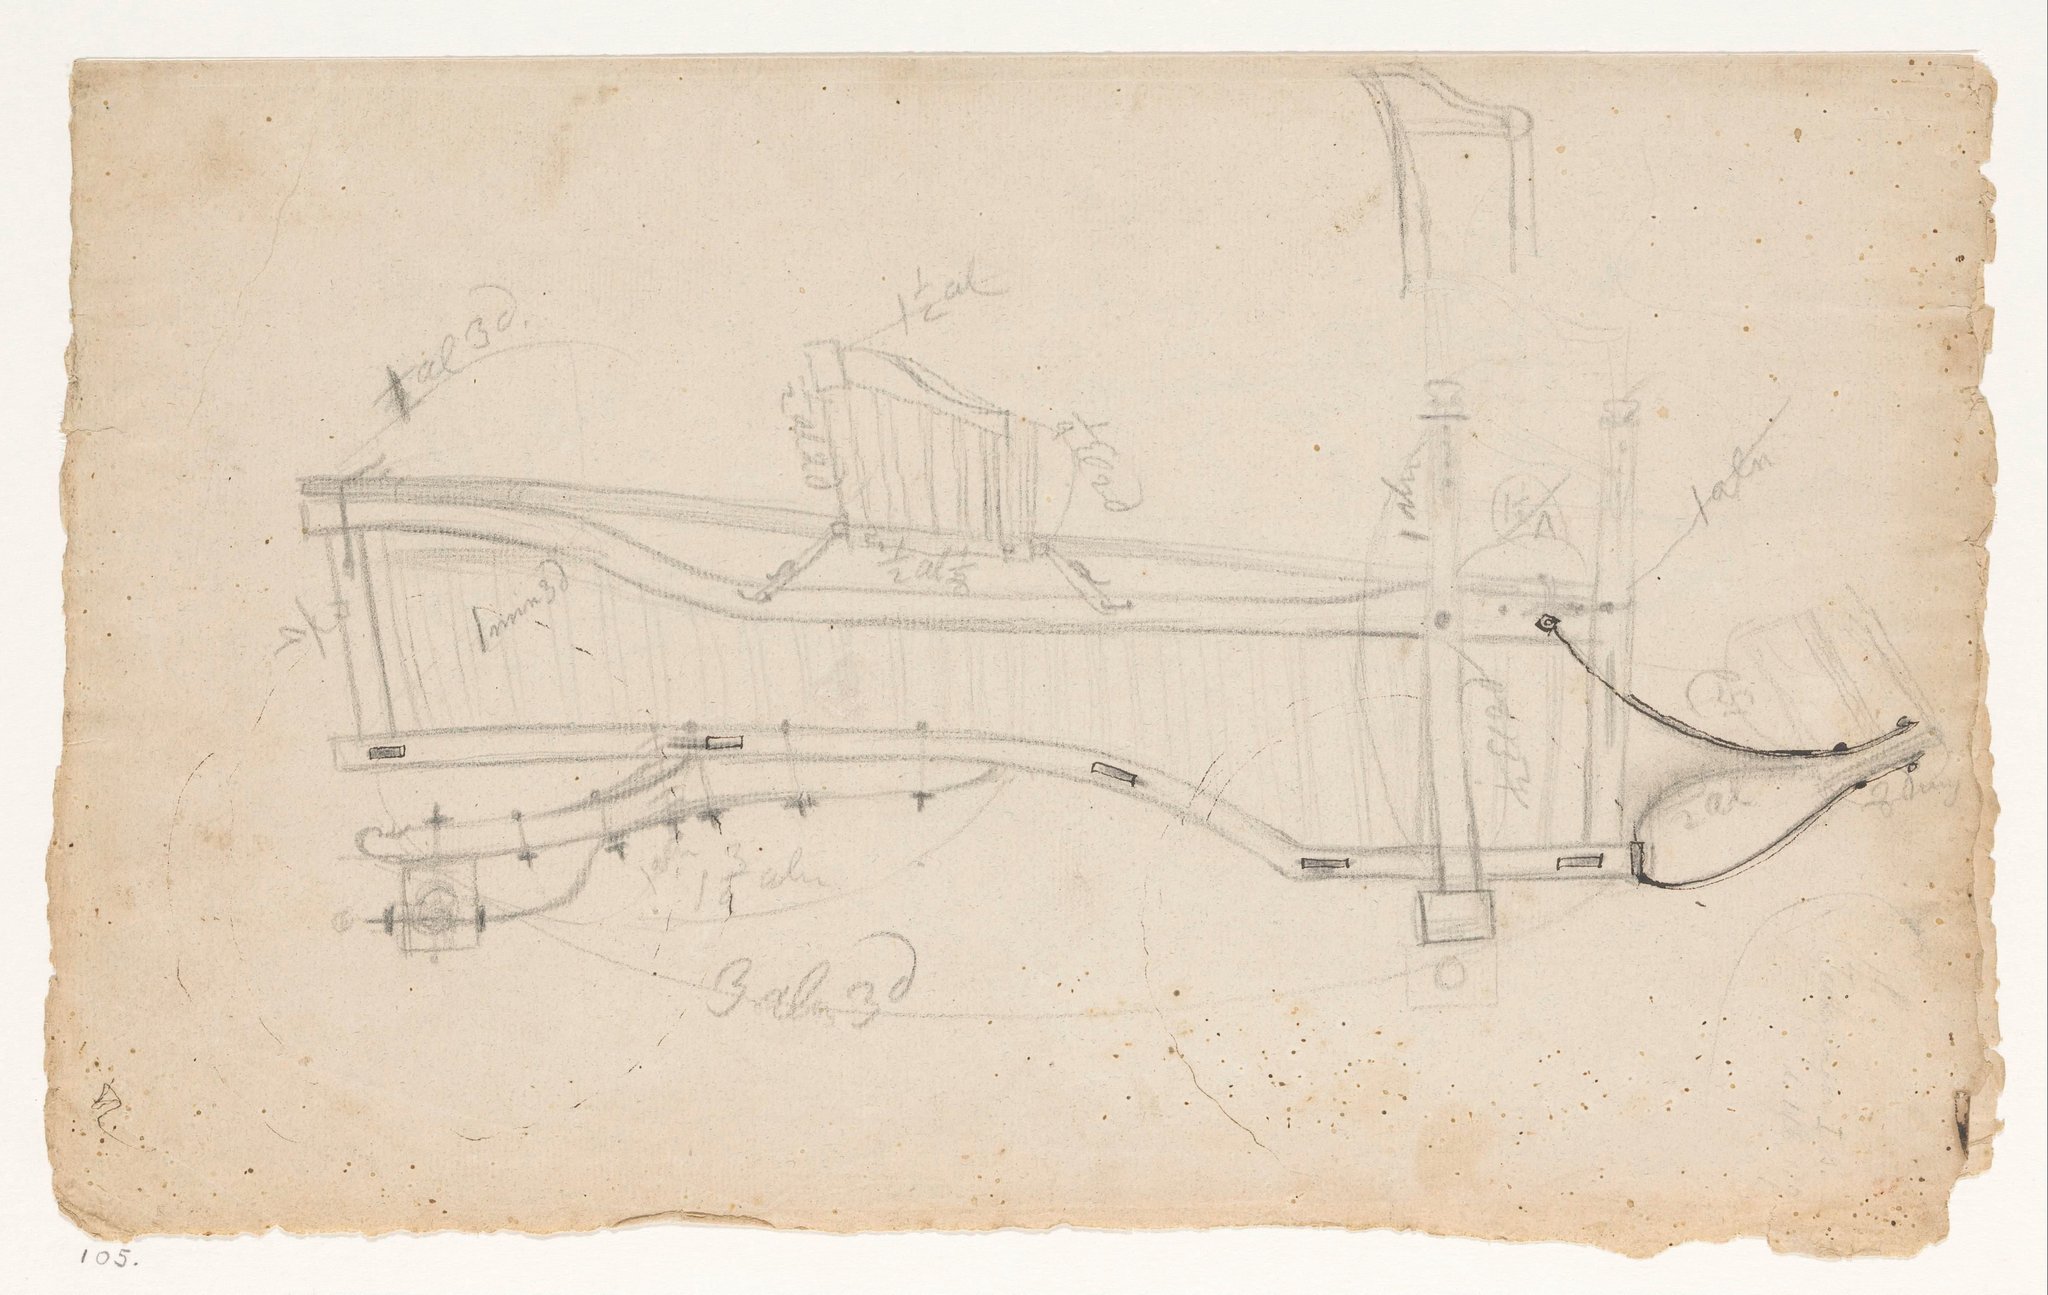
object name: drawing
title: Zweedse slede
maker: jan brandes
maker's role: draughtsman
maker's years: 1743-1808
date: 1787-1808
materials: ink, paper, pencil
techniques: pen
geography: skälsebo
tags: sleigh, sledge (non-sport)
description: Dubbelgevouwen blad met twee schetsen van een deel van een Zweedse arrenslee.